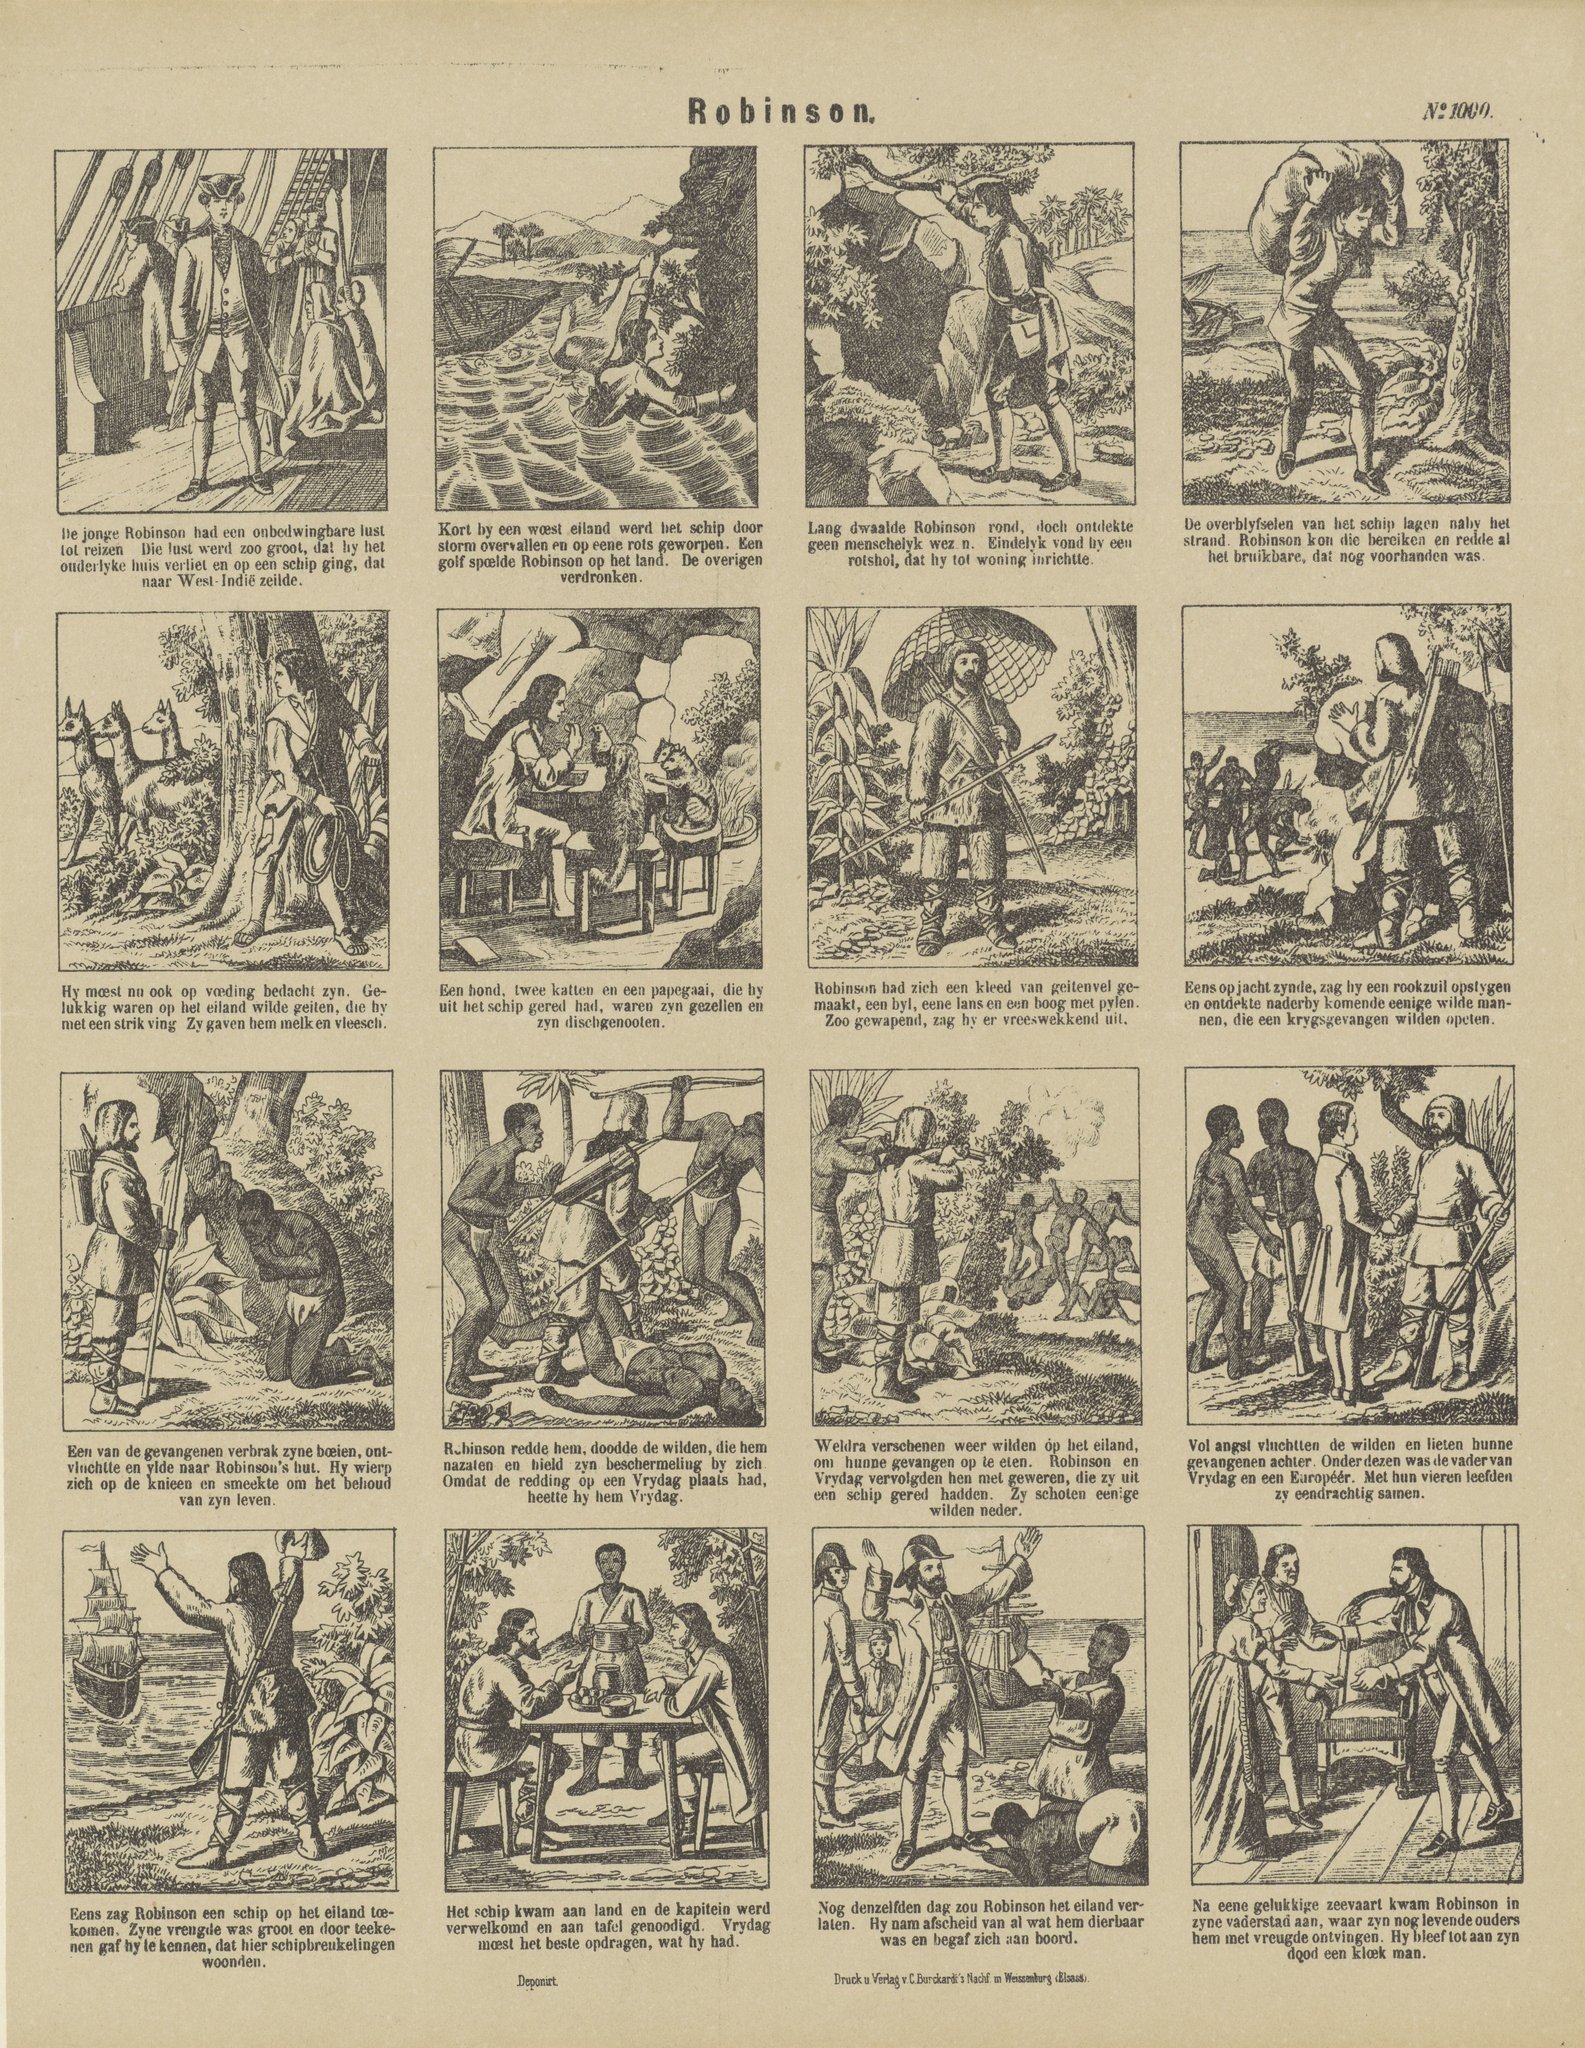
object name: print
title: Robinson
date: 1889-1906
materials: paper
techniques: letterpress printing, lithograph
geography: wissembourg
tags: (scenes from) specific works of literature: defoe, robinson crusoe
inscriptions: collector's mark: Lugt 2760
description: Blad met 16 voorstellingen uit het verhaal van Robinson Crusoe die strandt op een eiland. Onder elke afbeelding een onderschrift. Genummerd rechtsboven: No. 1000.